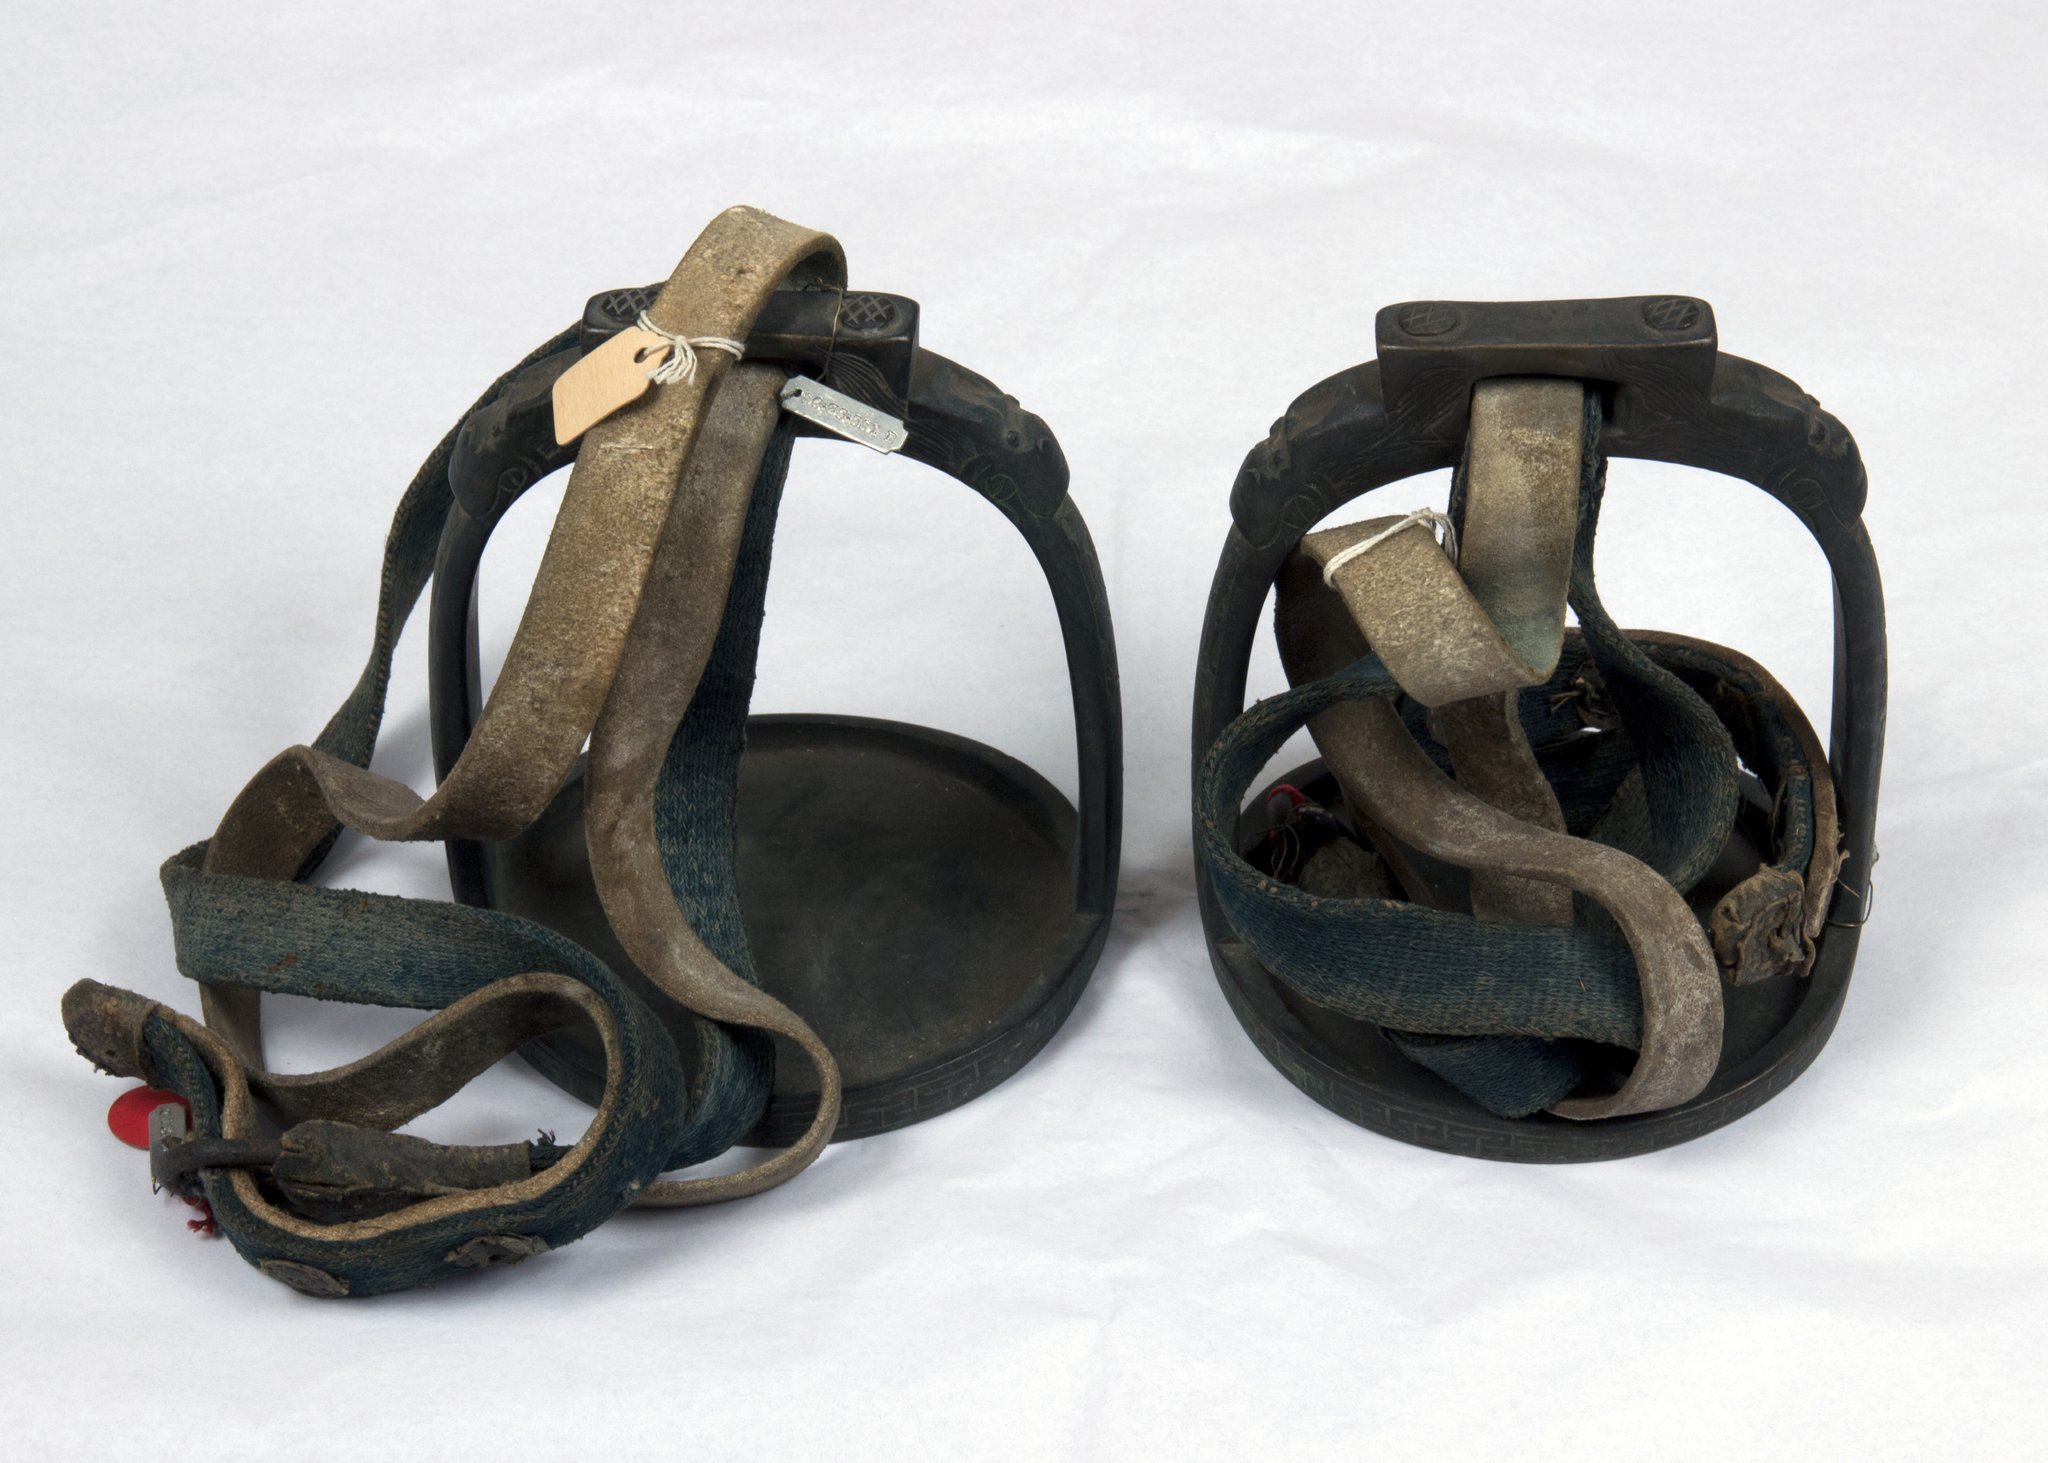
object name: stirrup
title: Pair of Stirrups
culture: chinese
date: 1801-1900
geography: china